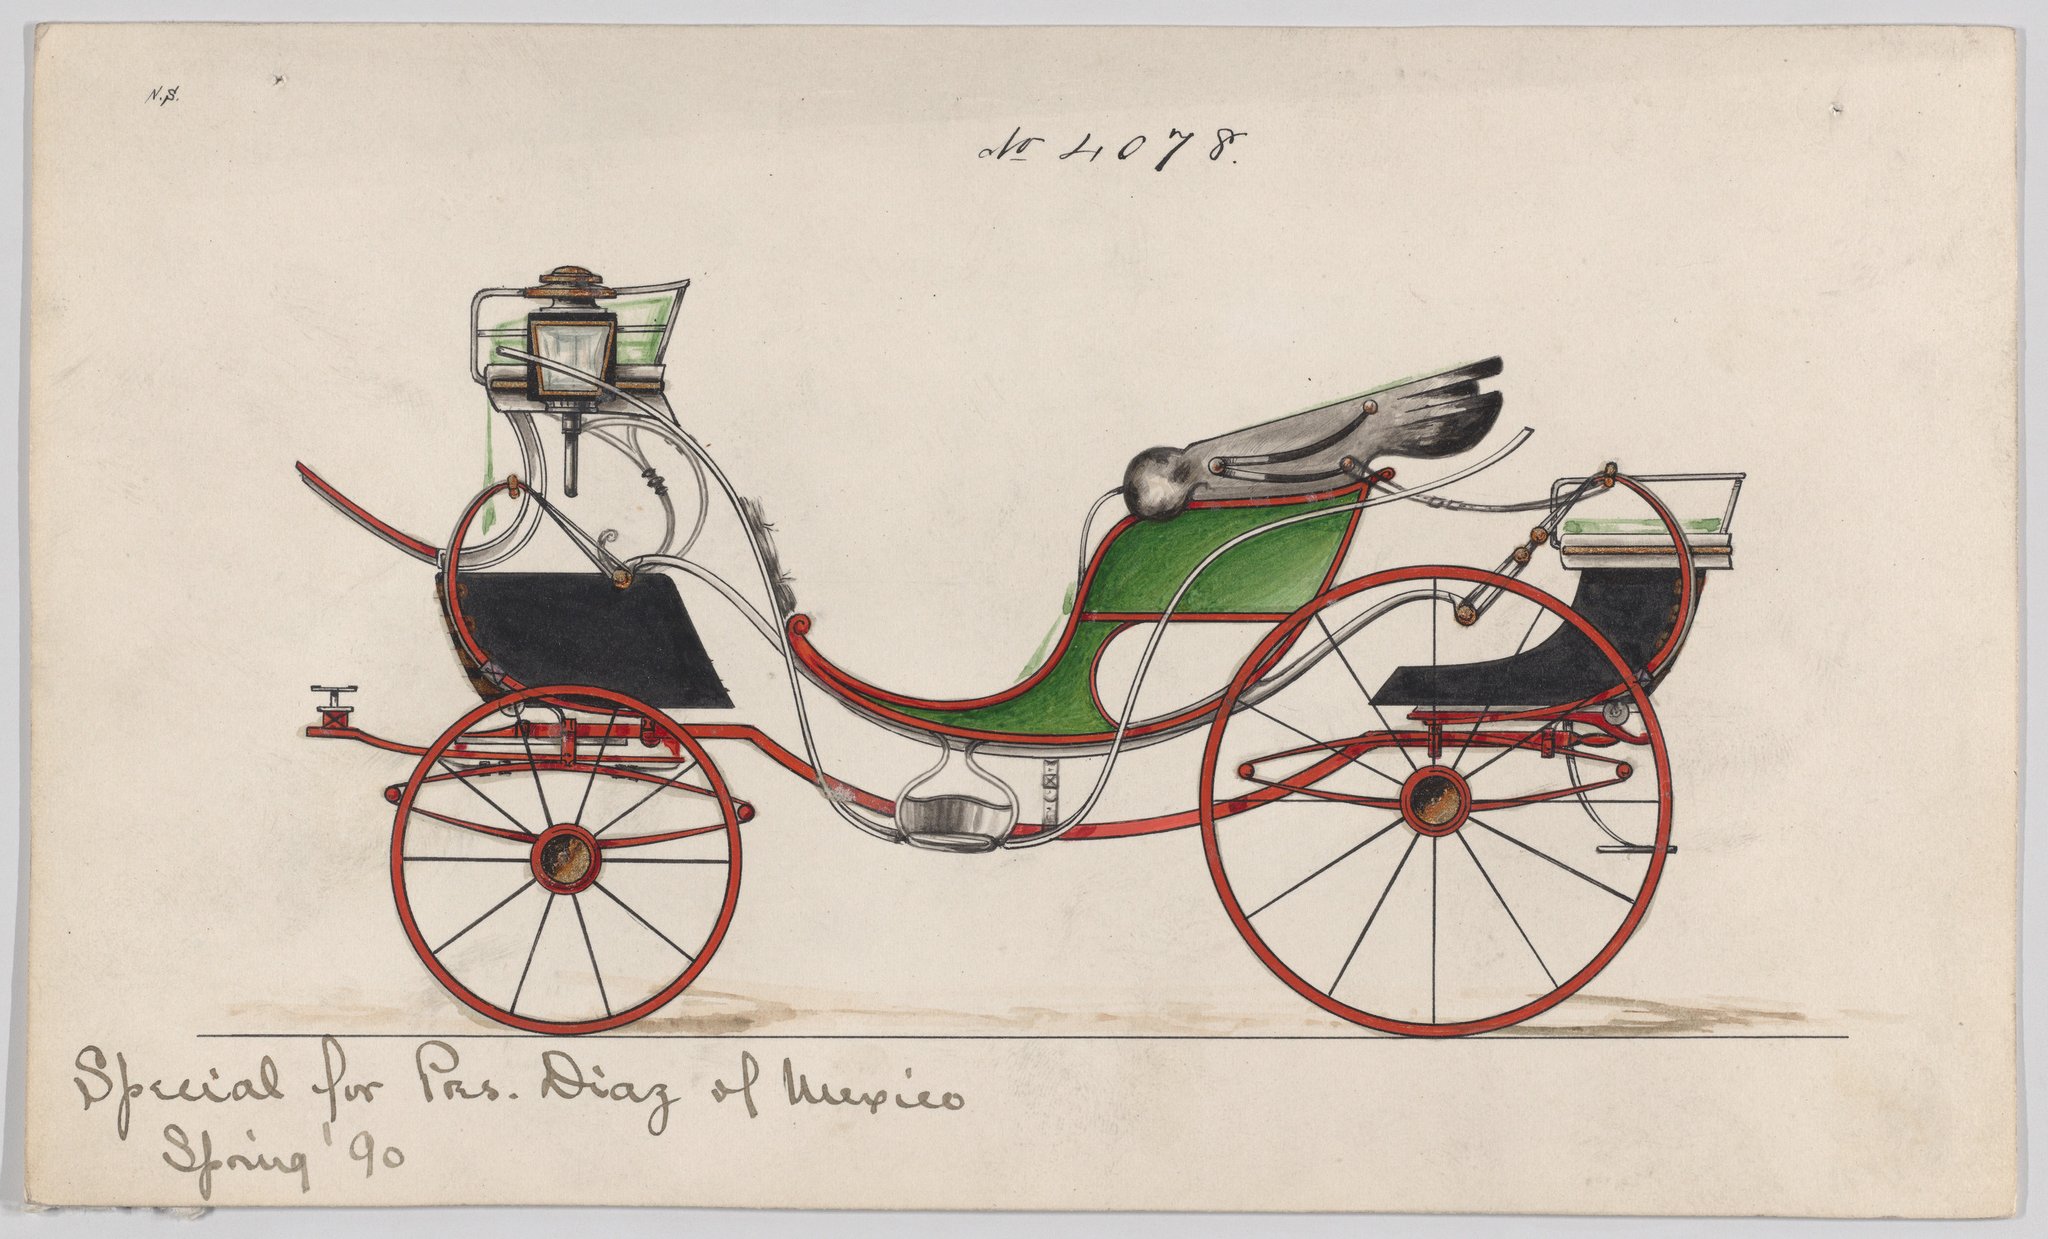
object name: drawing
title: Victoria #4078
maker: brewster & co.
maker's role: manufacturer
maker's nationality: american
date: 1890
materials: gouache, gum arabic, ink, watercolor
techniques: pen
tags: carriages